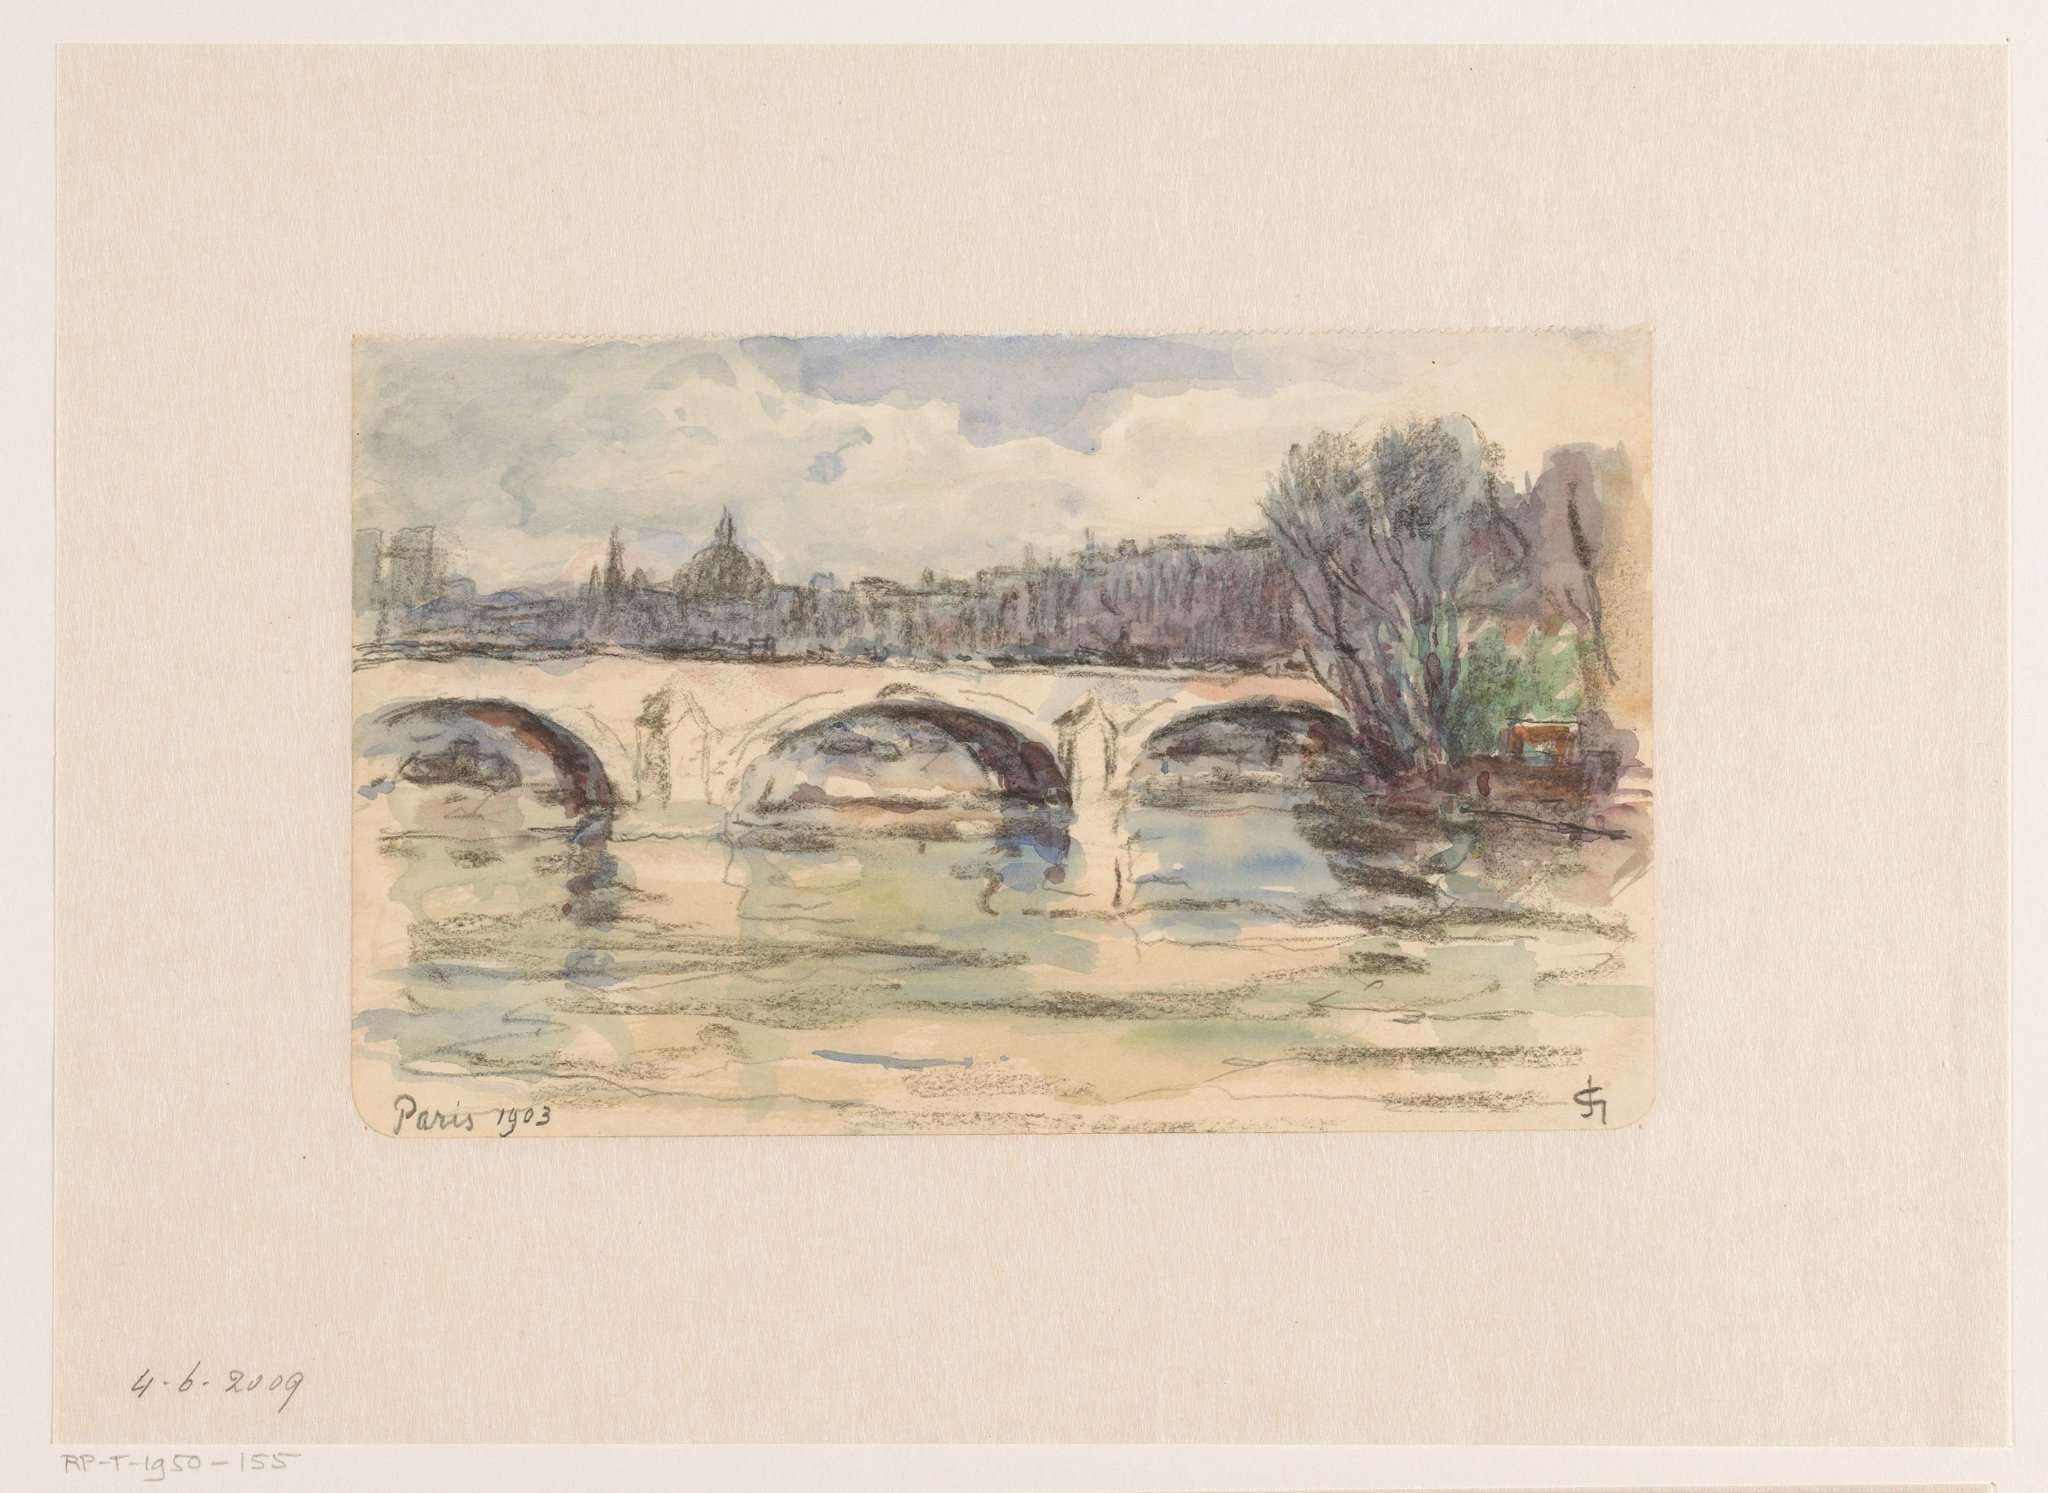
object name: watercolor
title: Brug over de Seine, Parijs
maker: carel nicolaas storm van s-gravesande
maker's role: draughtsman, print maker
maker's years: 1841-1924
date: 1903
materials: chalk, paper, watercolor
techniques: brush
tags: bridge in city across river, canal, etc., france, paris